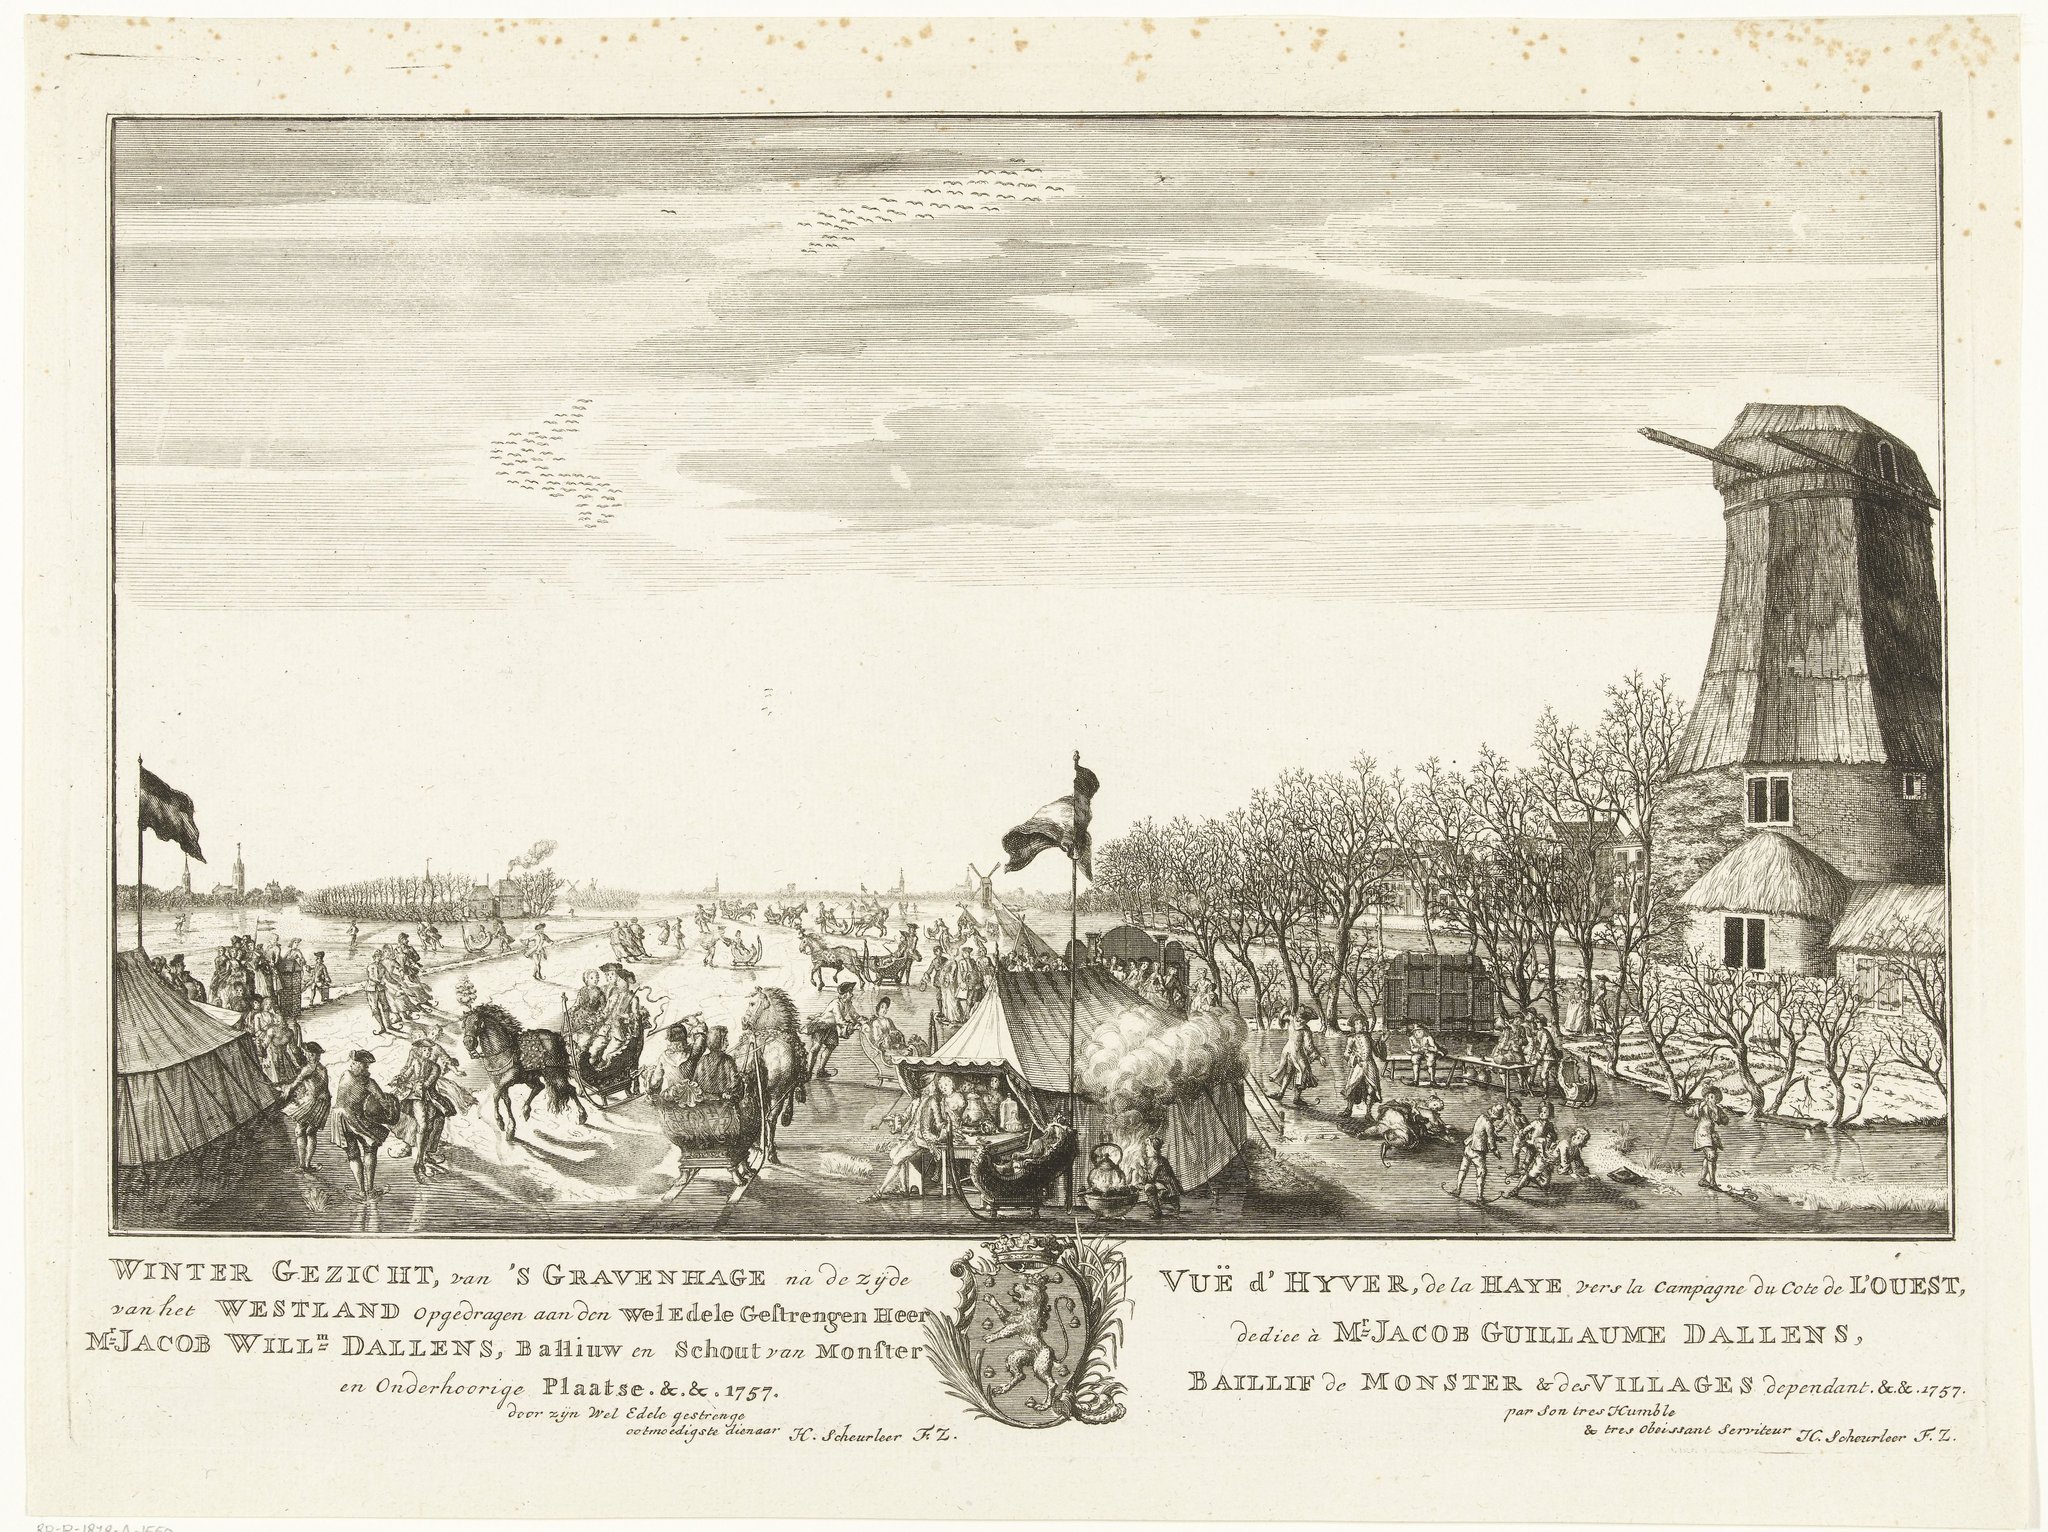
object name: print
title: Winter gezicht, van 's Gravenhage na de zijde van het Westland / Vuë d'hyver, de La Haye vers la campagne du cote de l'ouest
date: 1757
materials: paper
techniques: engraving, etching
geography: the hague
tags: winter landscape; landscape symbolizing winter (the four seasons of the year), skates (winter sports), sledge, sleigh (winter sports), windmill, playing with snow and ice, armorial bearing, heraldry, the hague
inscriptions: collector's mark: Lugt 2228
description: IJsvermaak op een ondergelopen stuk land te Den Haag richting het Westland. Rechts de Grut- of Gortmolen. Op het ijs schaatsers en arrensleeën, in het midden een koek-en-zopiekraam. Links op de achtergrond de contouren van Delft, in het midden kerken van enkele dorpen in het Westland. Onder de voorstelling de titel en opdracht in het Nederlands en Frans, met in het midden het familiewapen van Jacob Willem Dallens, baljuw en schout van Monster. Prent uit een serie van achttien gezichten in en om Den Haag.